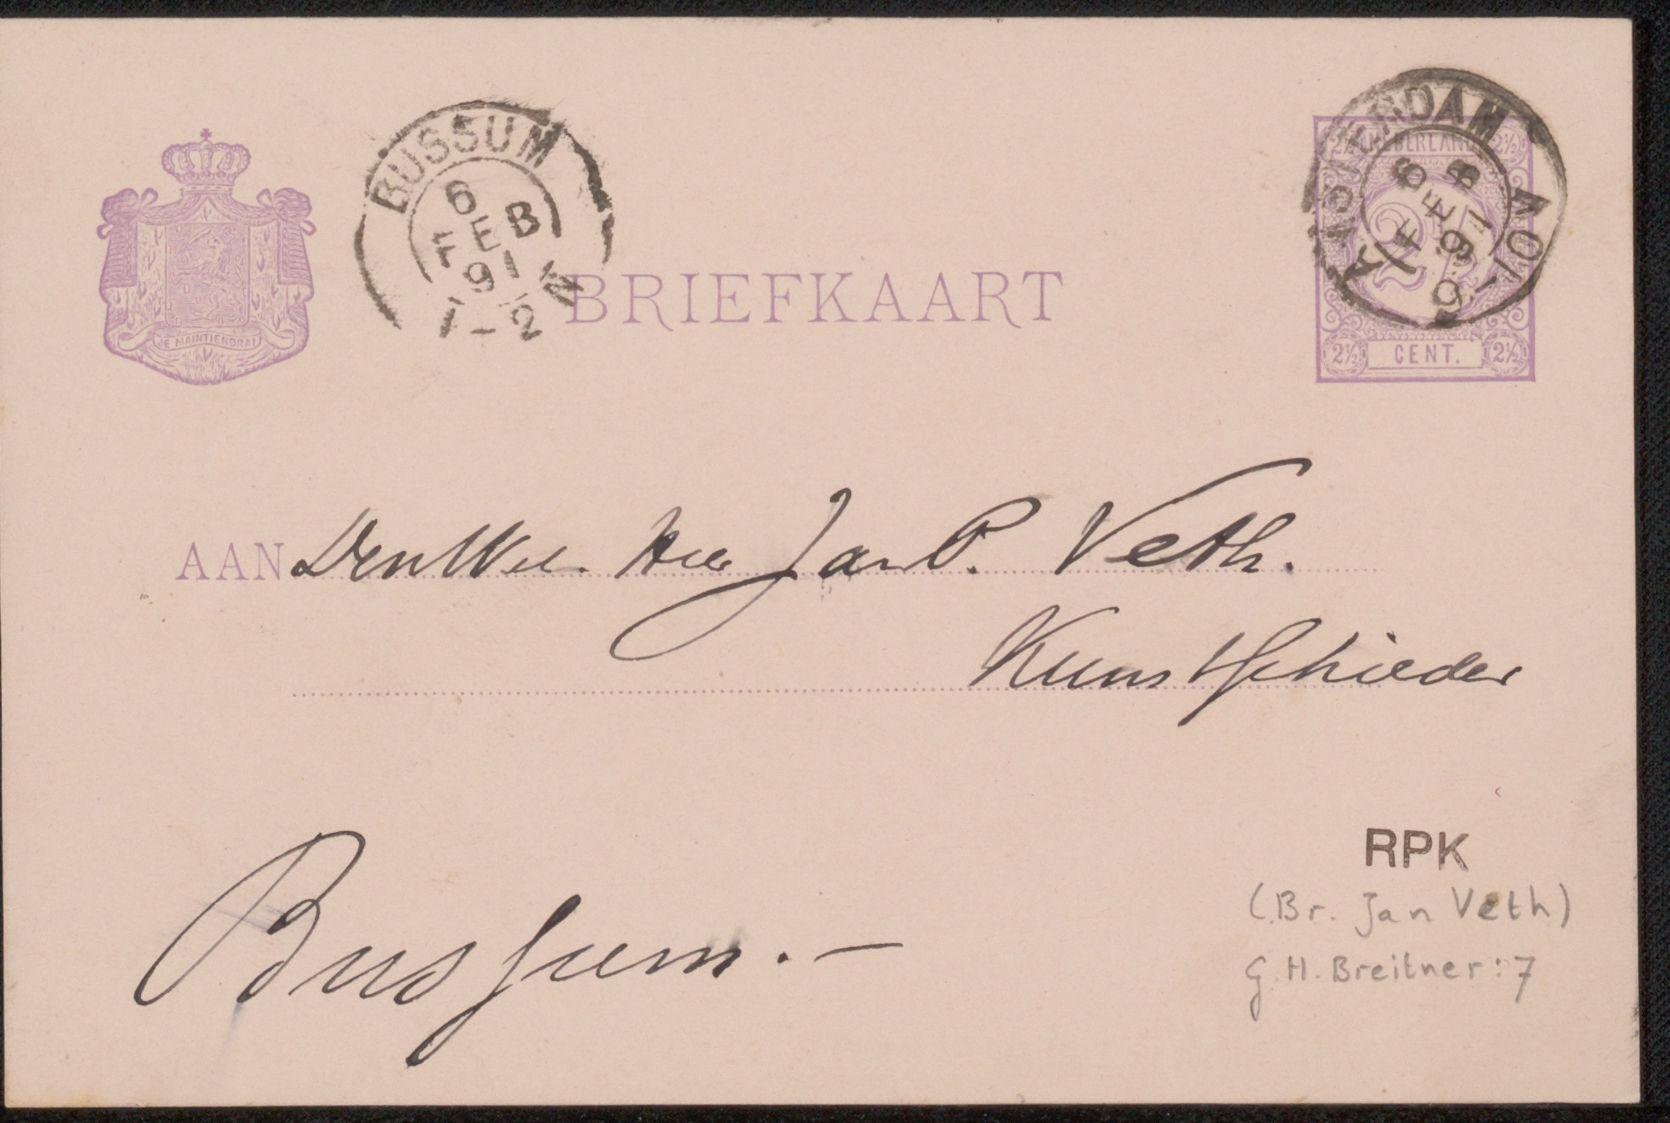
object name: postcard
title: Briefkaart aan Jan Veth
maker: george hendrik breitner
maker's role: draughtsman, painter, print maker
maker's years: 1857-1923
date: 1891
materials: cardboard, ink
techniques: pen, writing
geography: amsterdam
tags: dordrecht, designer, jan veth, exhibition ~ art, printed matter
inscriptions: collector's mark: ‘RPK’